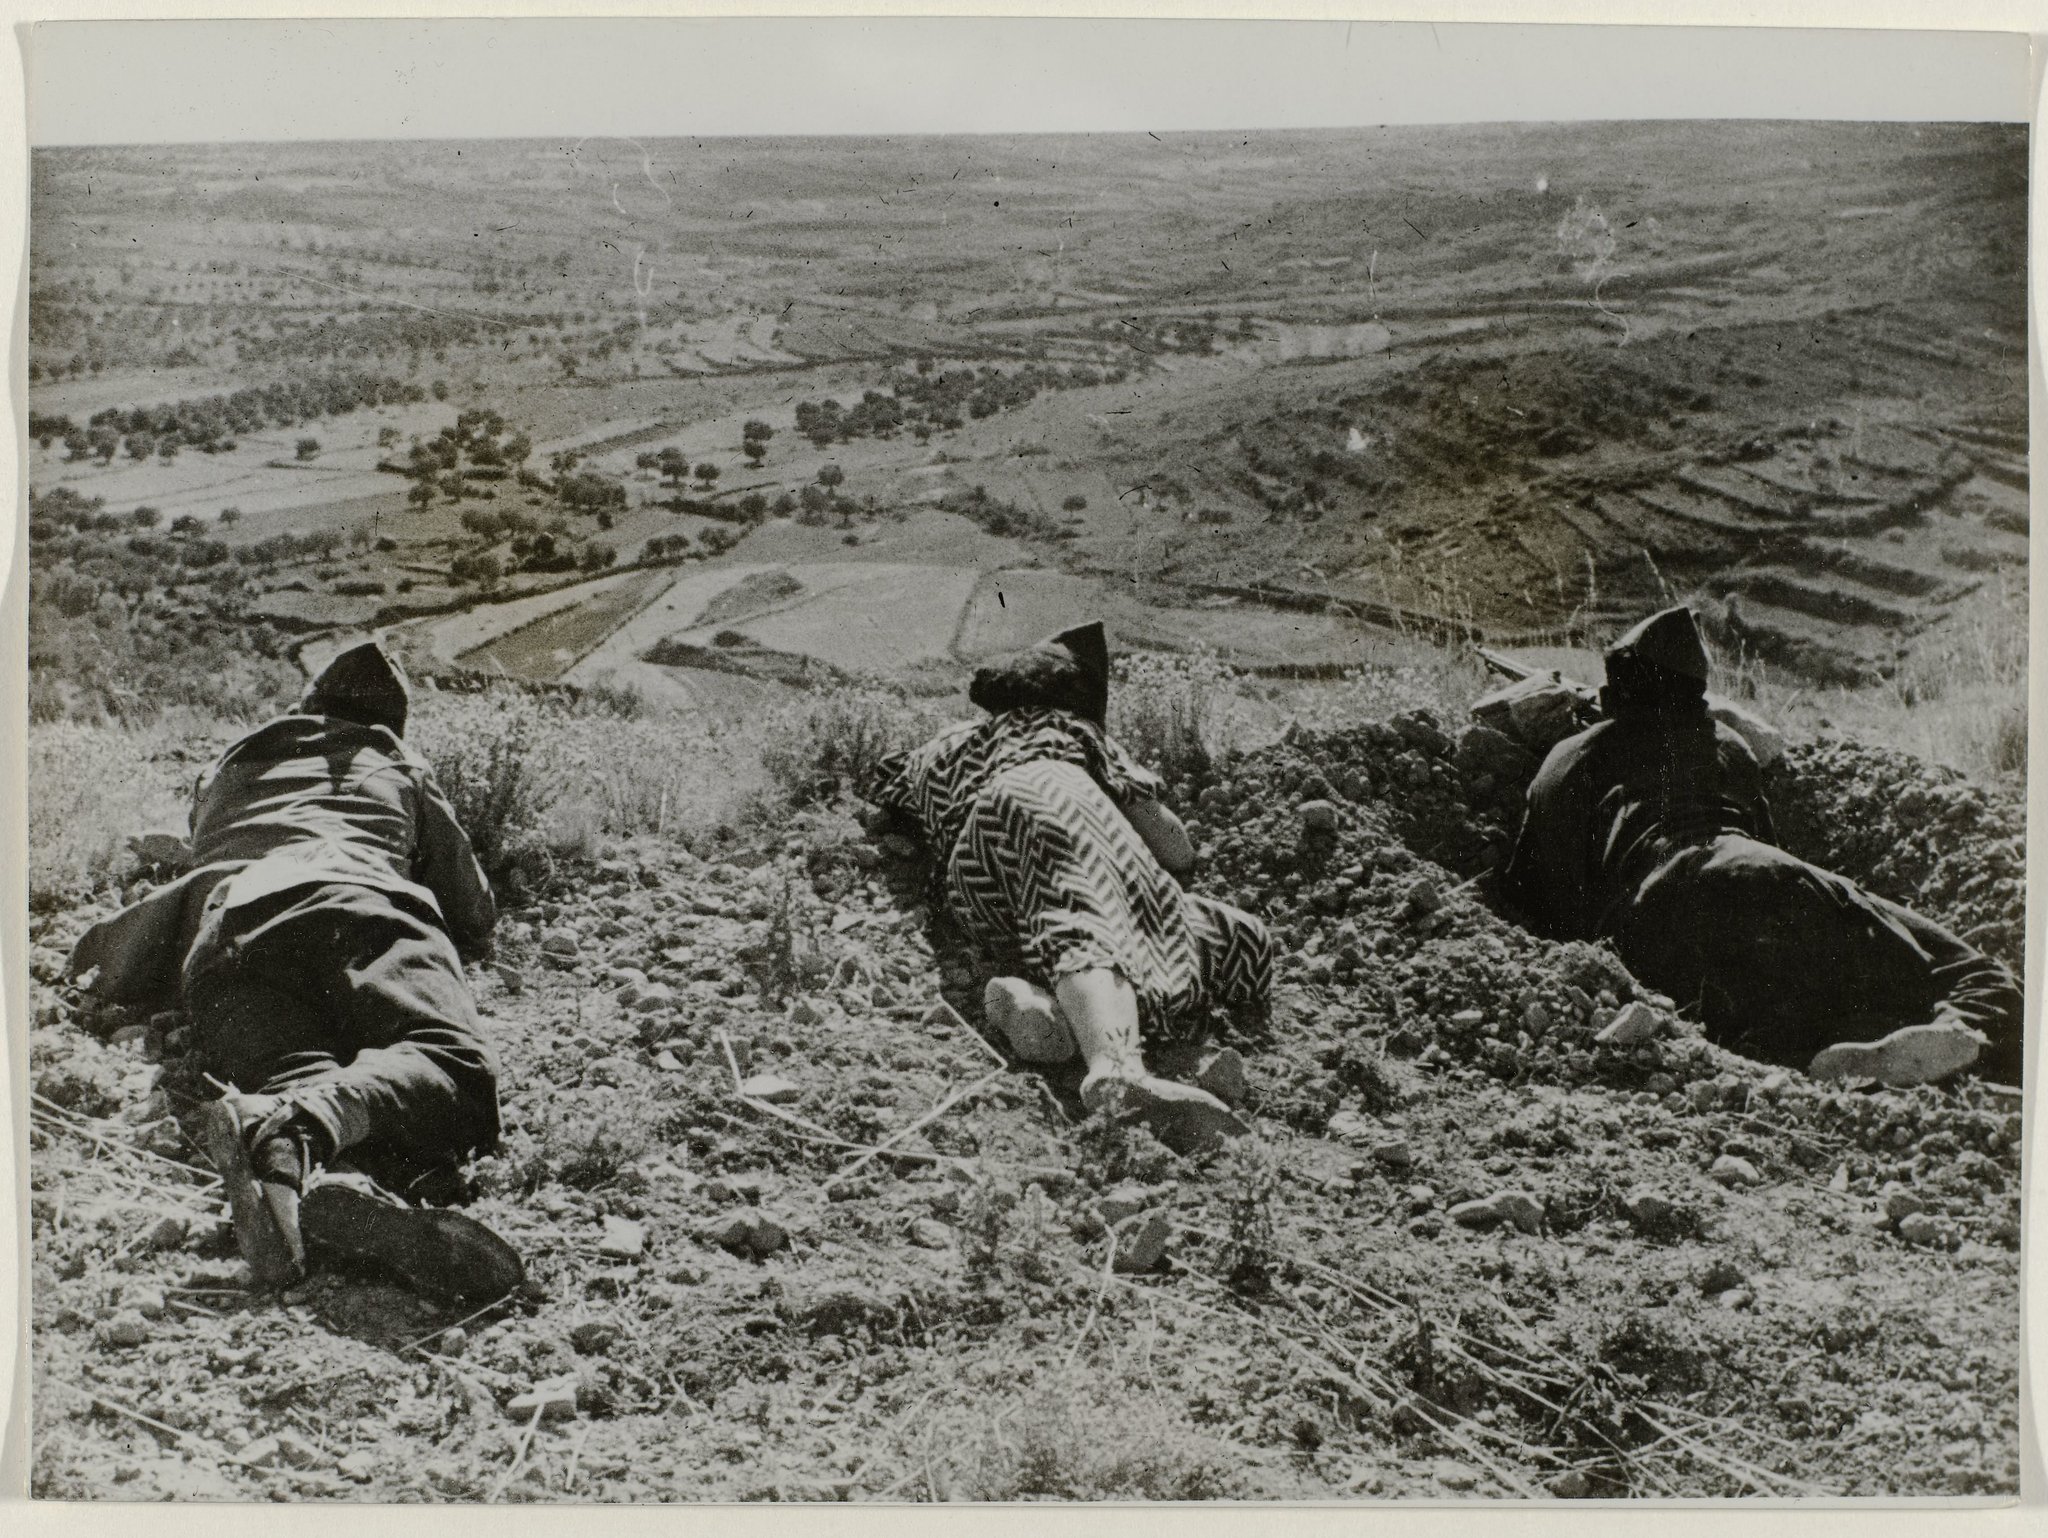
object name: photograph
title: Vrouwelijke schutter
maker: Anonymous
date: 1936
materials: photographic support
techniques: gelatin silver print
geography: amsterdam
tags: spain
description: Een vrouwelijke schutter neemt posititie tussen twee republikeinse militairen op het Aragon front tijdens de Spaanse Burgeroorlog, 11 september 1936. Op de achterzijde een stempel een blaadje met perstekst in het Engels.